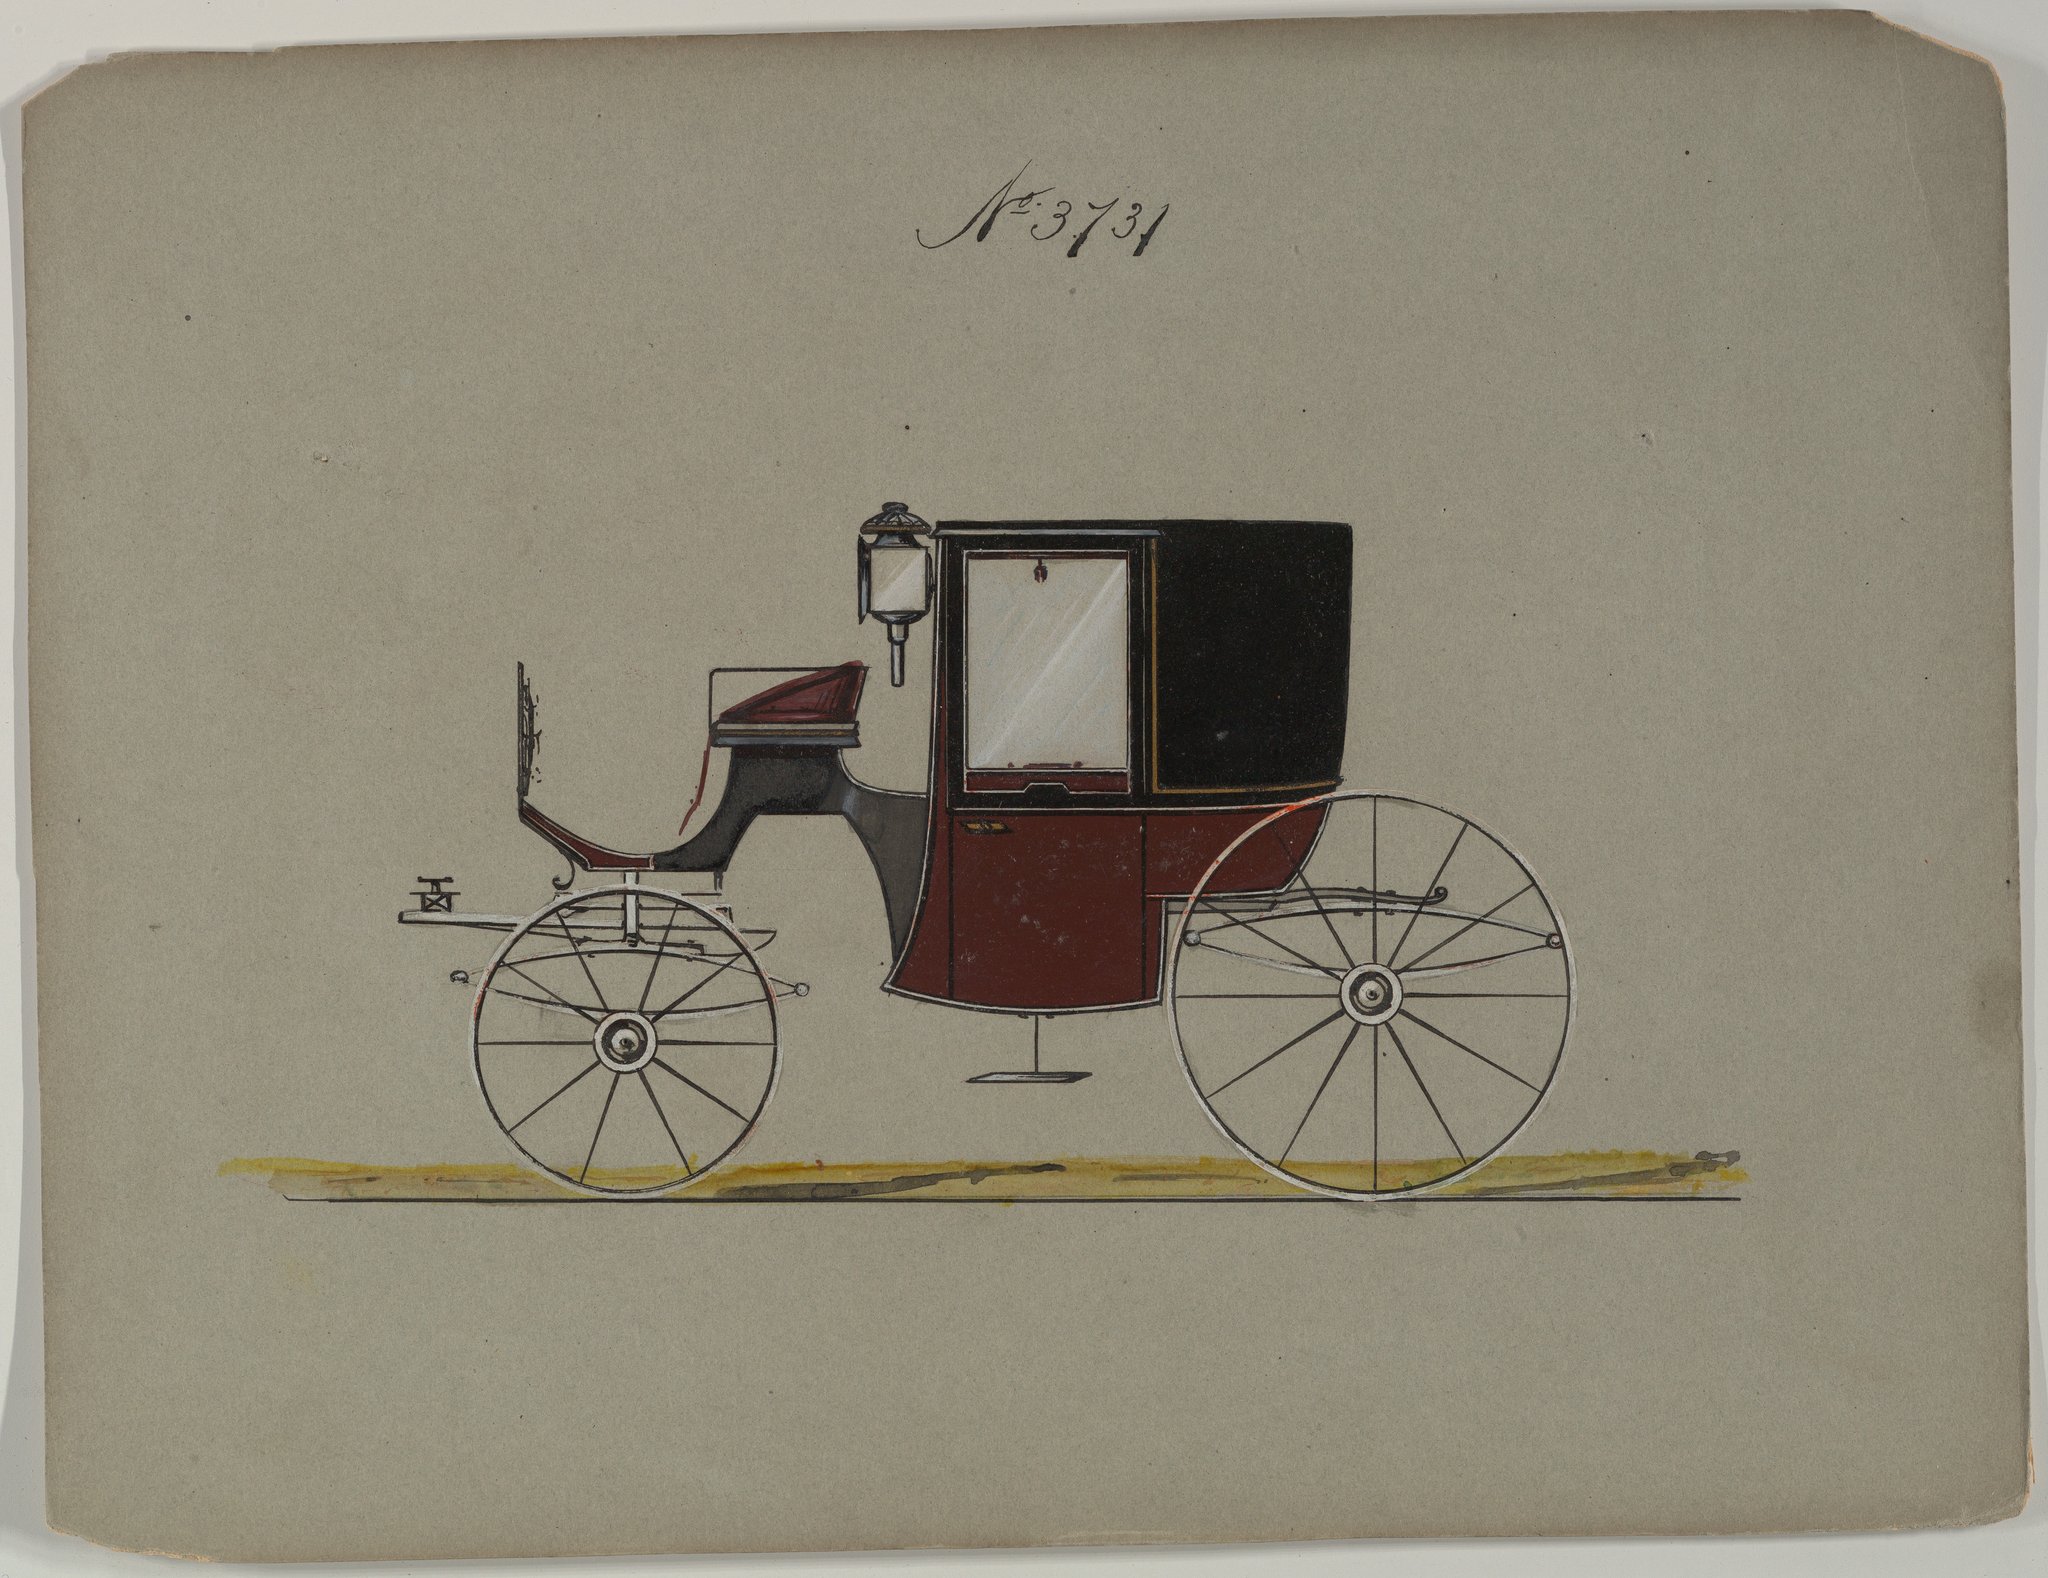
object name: drawing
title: Brougham #3731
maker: brewster & co.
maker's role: manufacturer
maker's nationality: american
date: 1881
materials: gouache, gum arabic, ink, watercolor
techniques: pen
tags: carriages